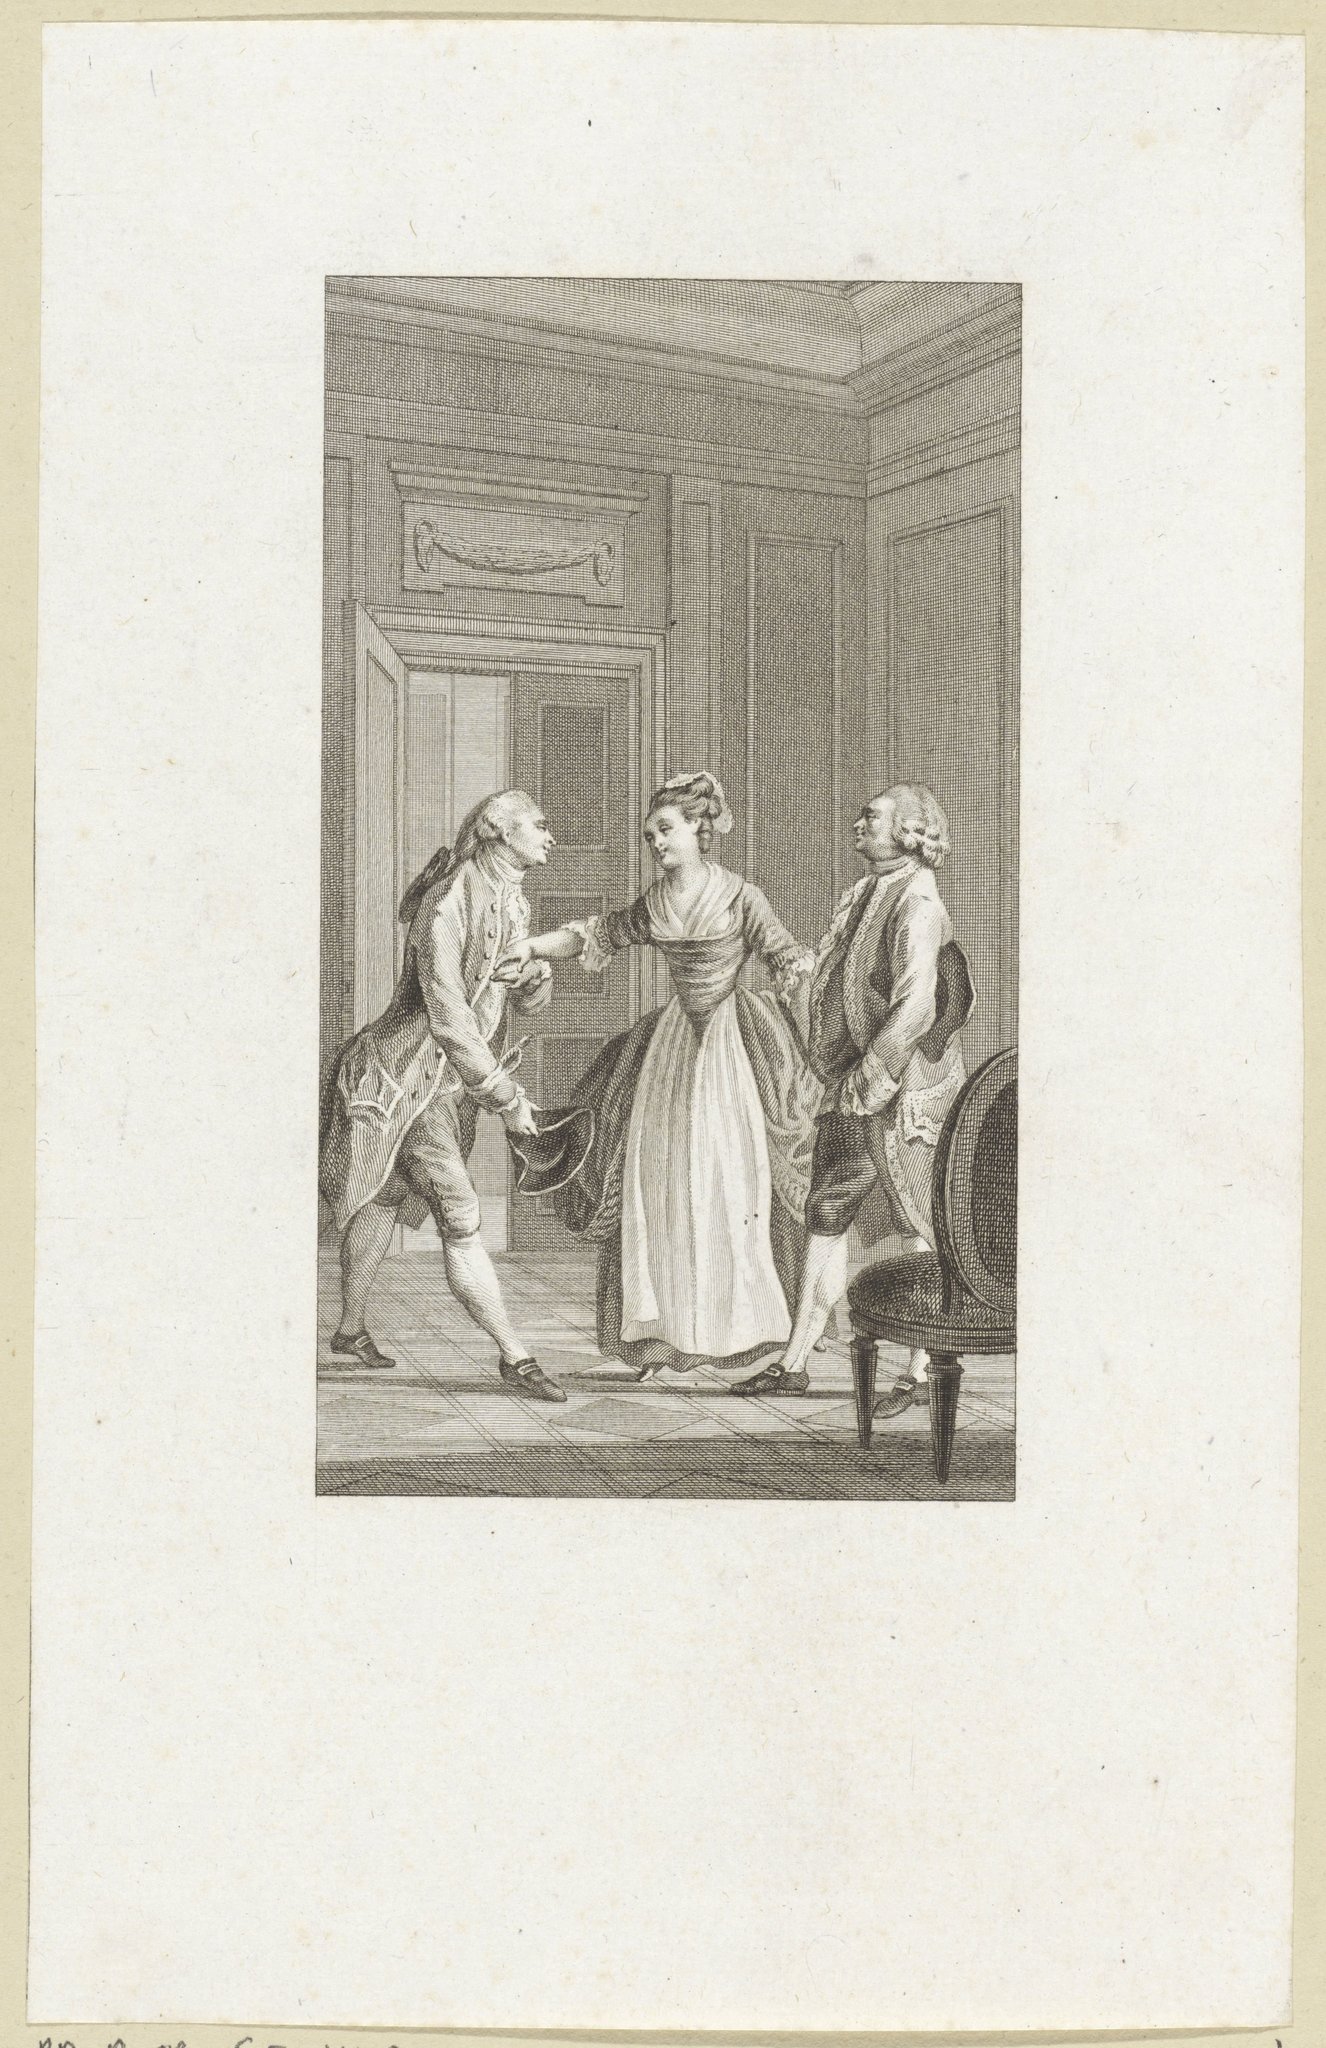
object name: print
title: Twee mannen en een vrouw in gesprek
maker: reinier vinkeles (i)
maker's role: draughtsman, print maker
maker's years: 1741-1816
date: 1778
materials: paper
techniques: engraving, etching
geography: amsterdam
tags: conversation, dialogue; conversation piece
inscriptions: collector's mark: Lugt 240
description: Proefdruk van een prent die mogelijk als illustratie is gebruikt in: Gellert, Christian Fürchtegott. Vier blyspeelen. Amsterdam: Gerrit Warnars en Petrus den Hengst, 17??.